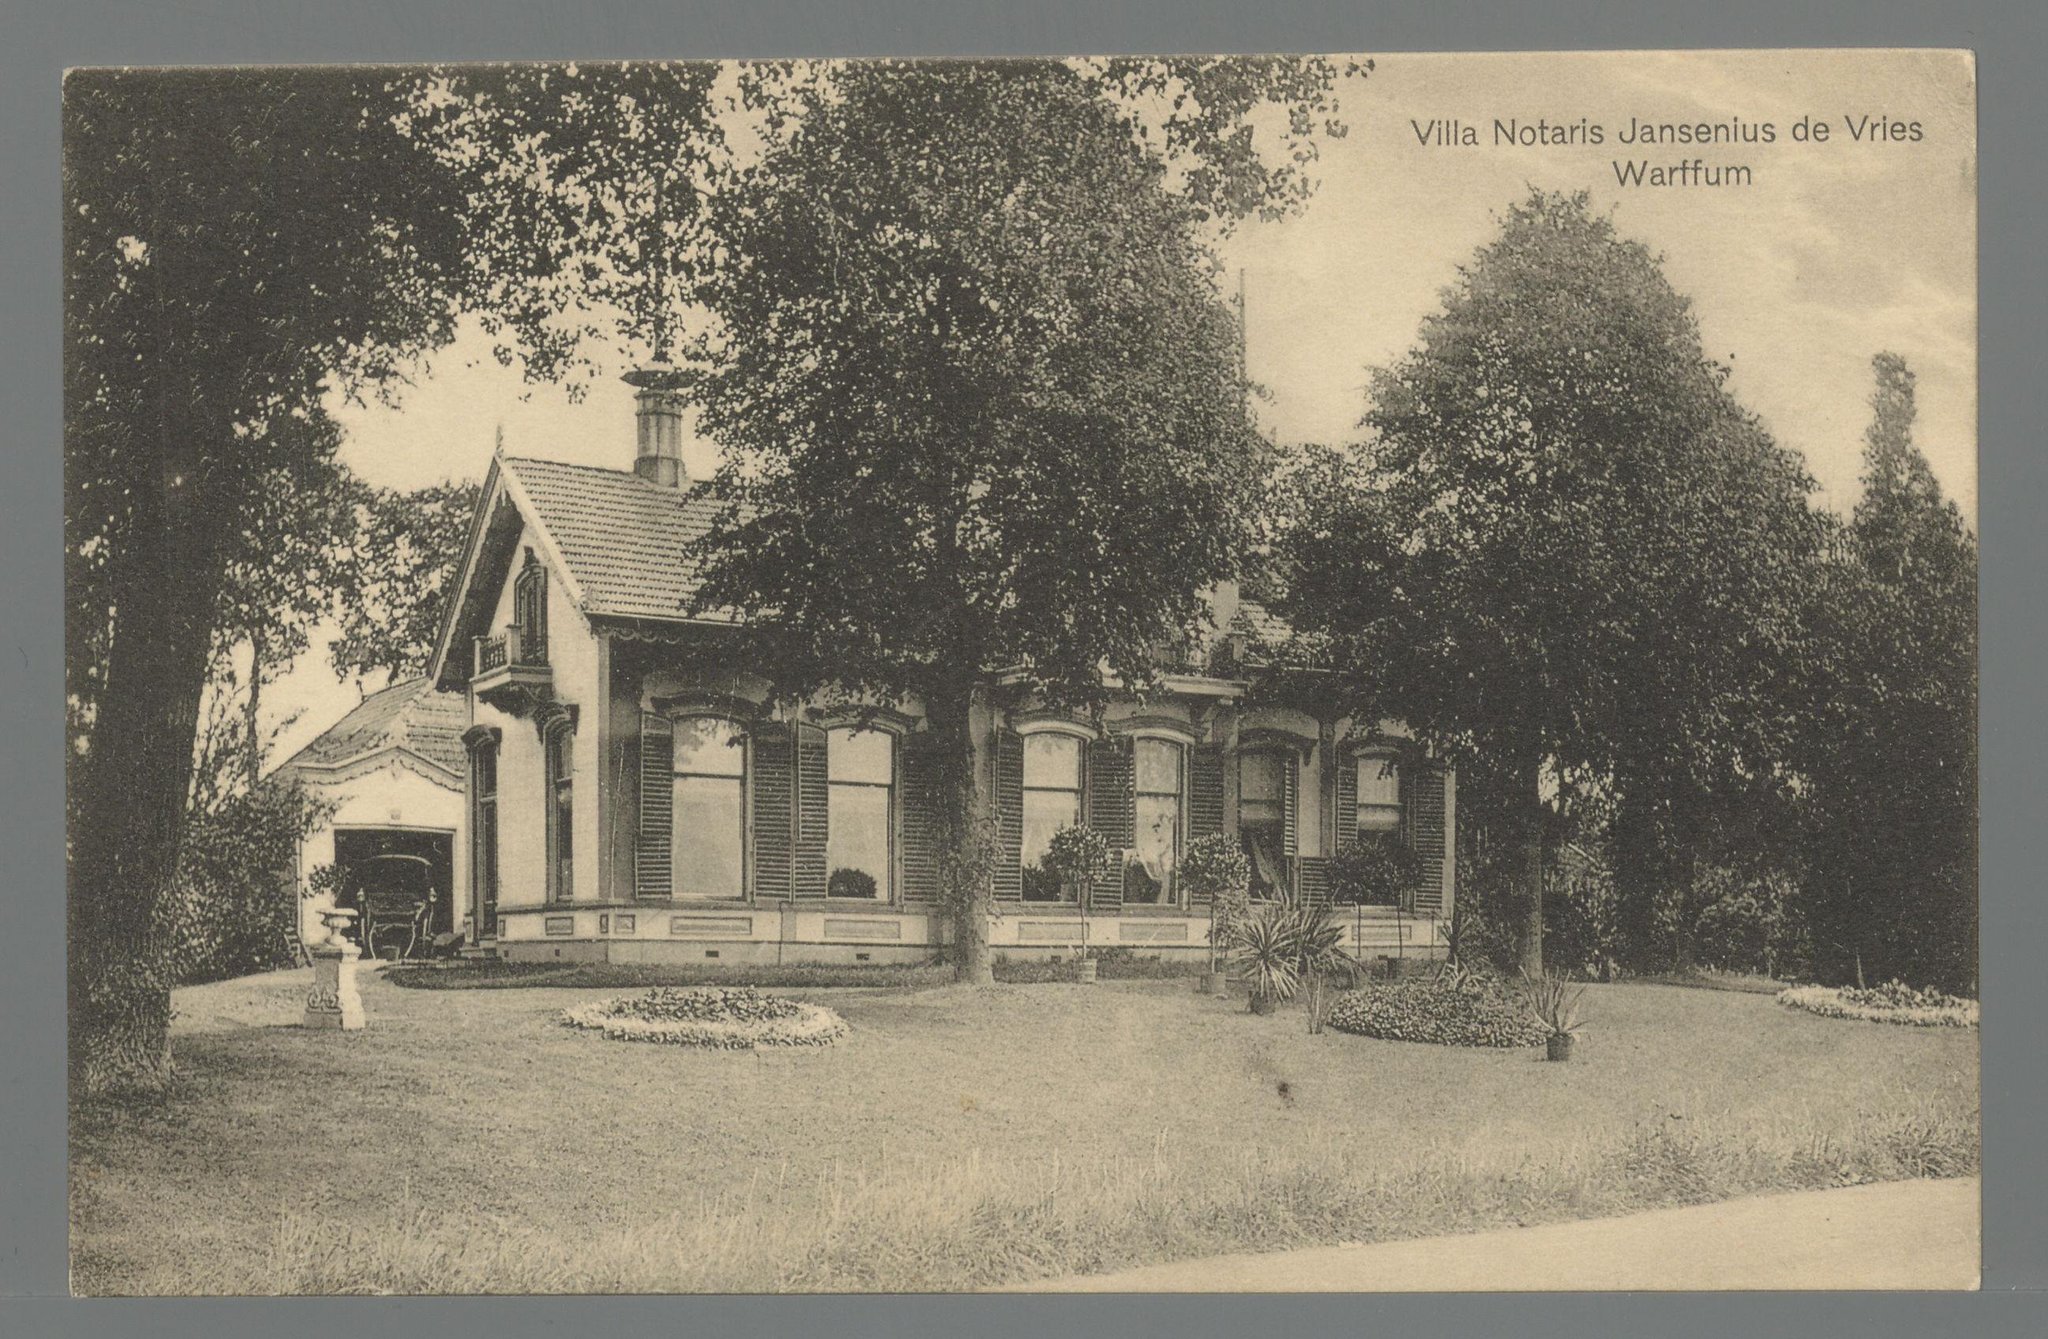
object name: photomechanical print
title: Villa Notaris Jansenius de Vries. Warffum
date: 1905-1915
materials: cardboard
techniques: photograph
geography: warffum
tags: villa